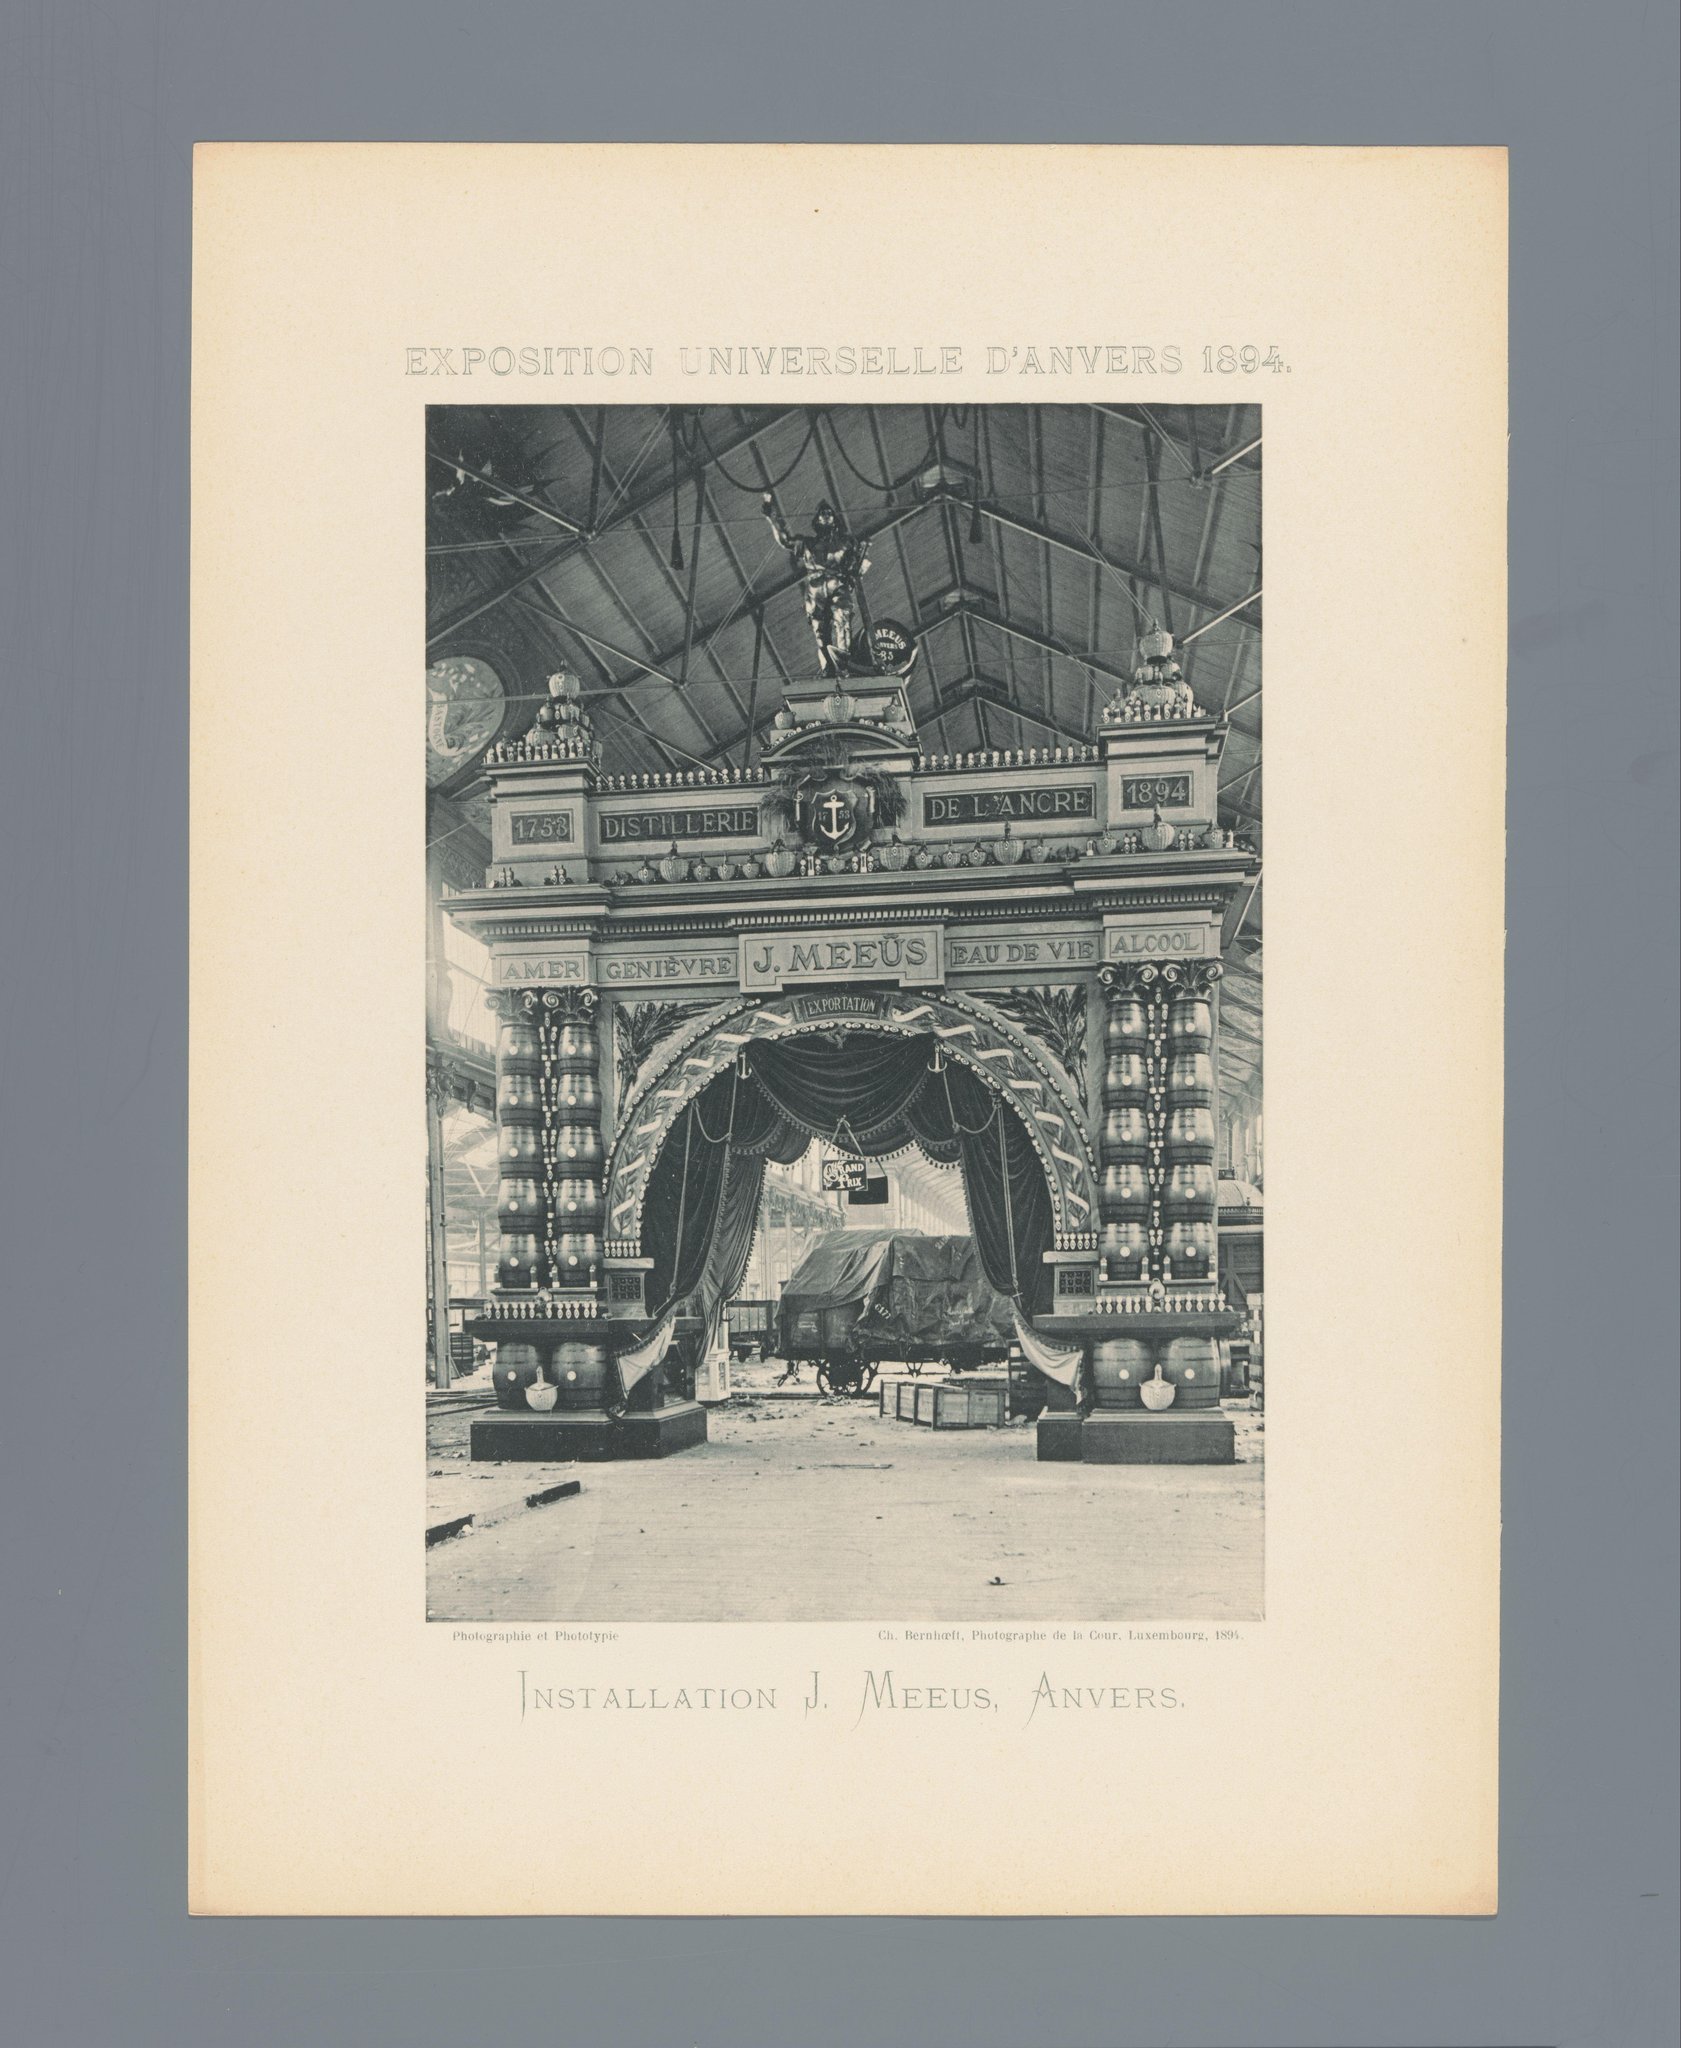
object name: photomechanical print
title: Triomfboog van J. Meeuw bij de Wereldtentoonstelling van 1894 te Antwerpen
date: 1894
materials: paper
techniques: photograph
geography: luxembourg city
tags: world fair, world exhibition, triumphal arch, antwerp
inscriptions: inscription: ‘Exposition Universelle D'Anvers 1894’